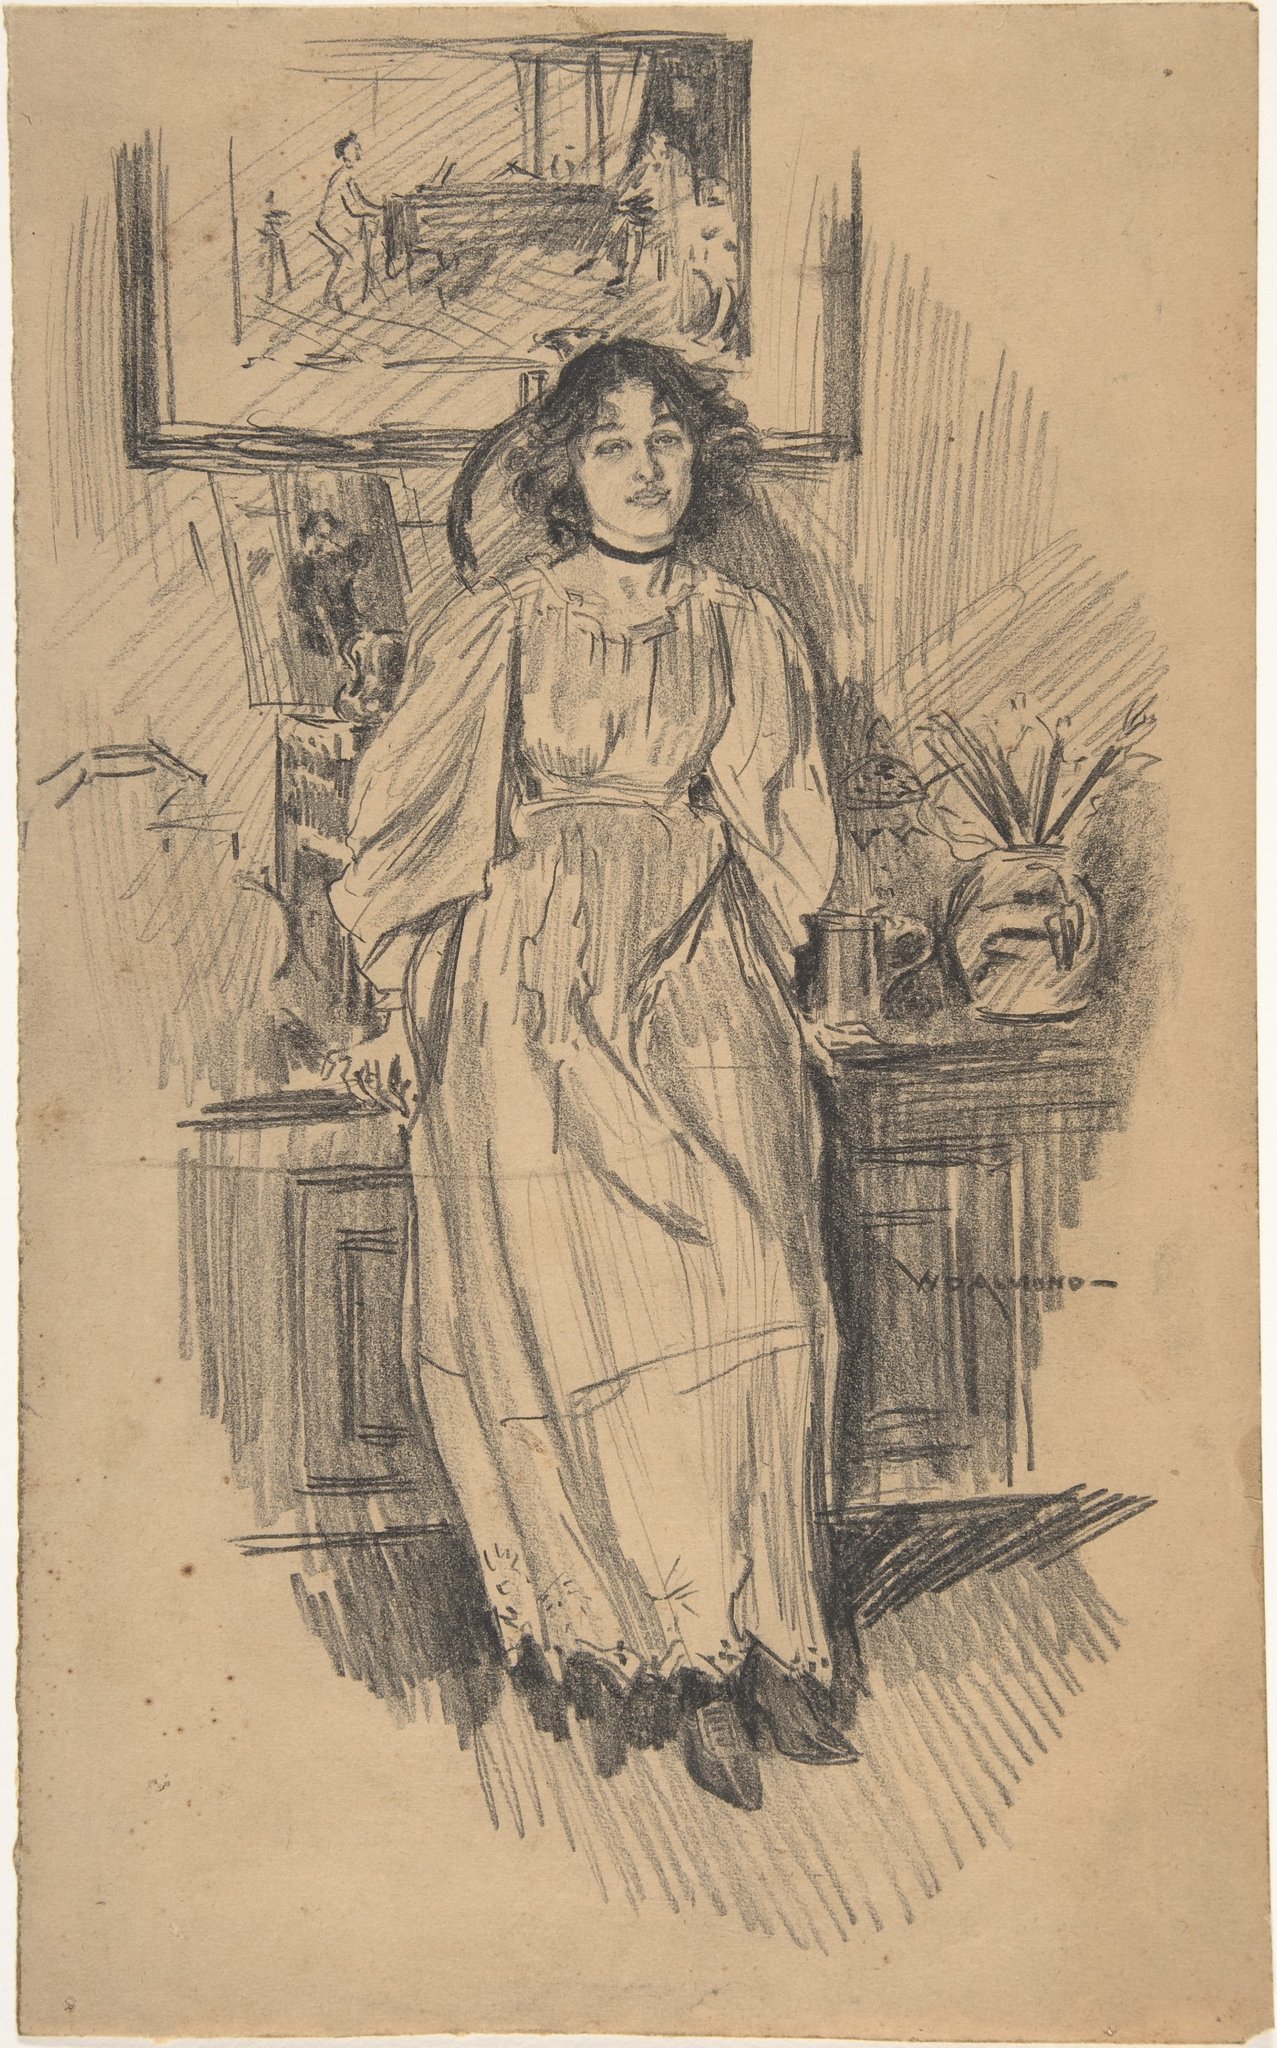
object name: drawing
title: Young Woman Leaning against a Low Cabinet in Artist's Studio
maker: william douglas almond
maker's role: artist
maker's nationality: british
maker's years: 1866-1916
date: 1867-1933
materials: graphite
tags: women,cabinets